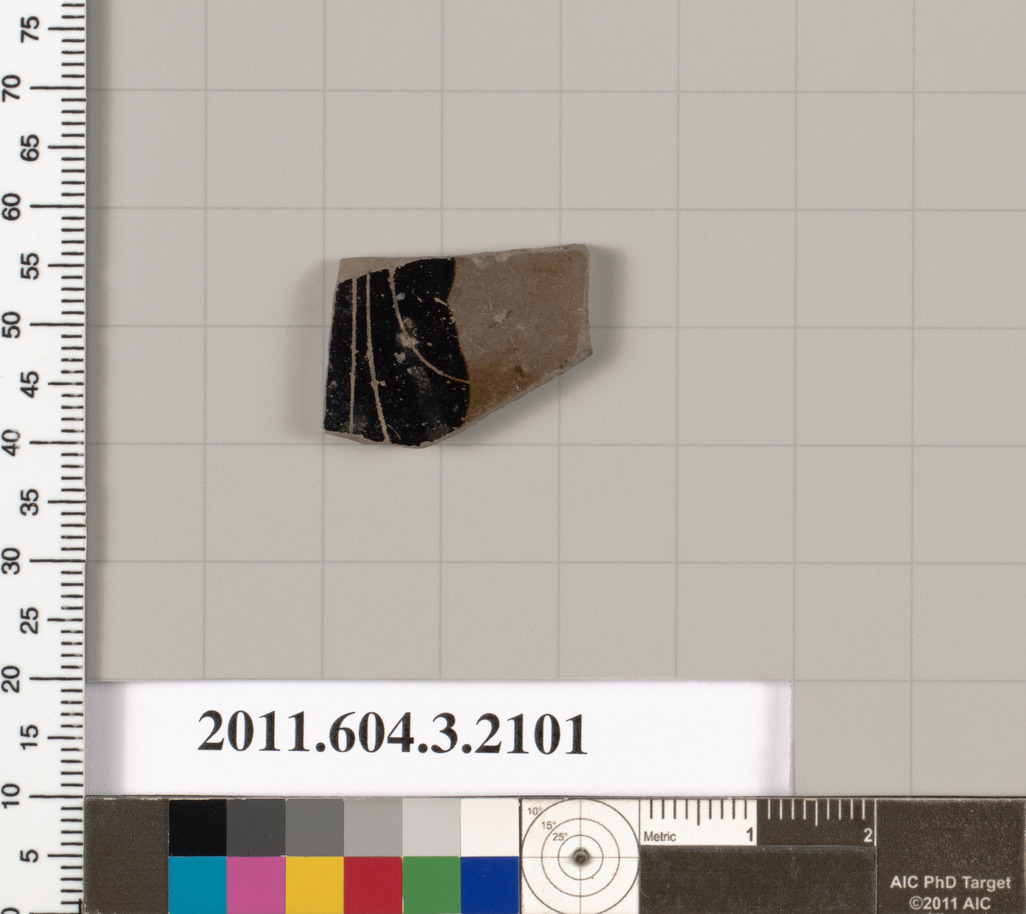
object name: kylix fragment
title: Terracotta fragment of a kylix (drinking cup)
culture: greek, attic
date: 534-501 BCE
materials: terracotta